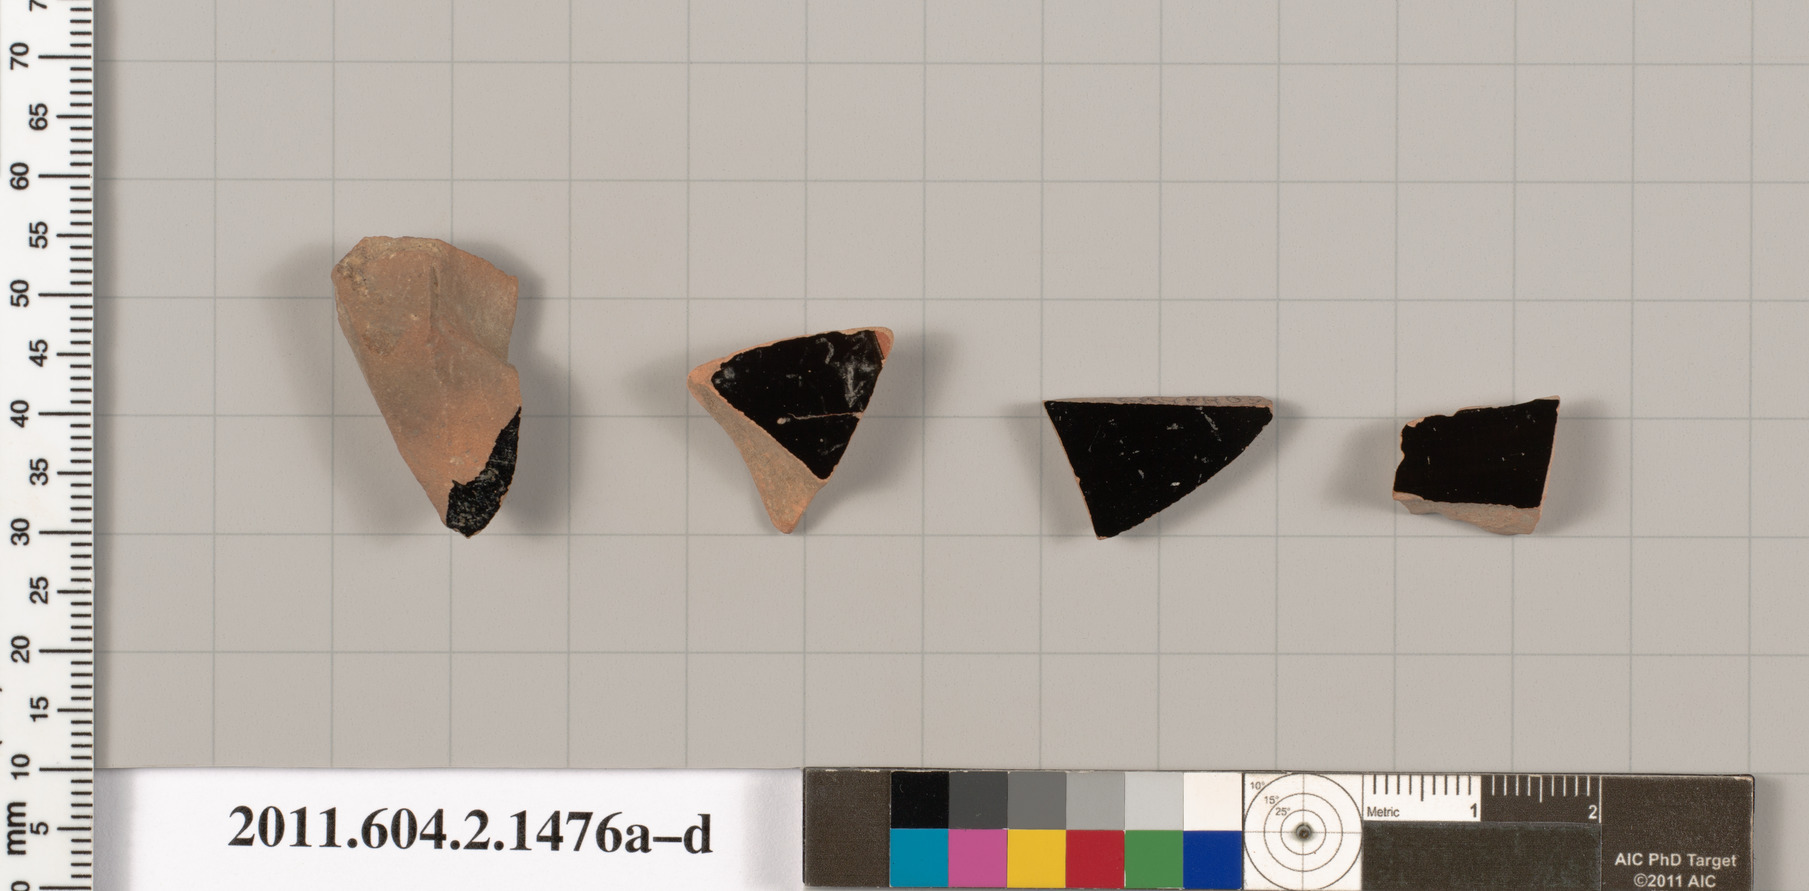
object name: skyphos fragment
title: Terracotta fragments of skyphoi (deep drinking cups)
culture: greek, attic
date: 600-401 BCE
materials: terracotta